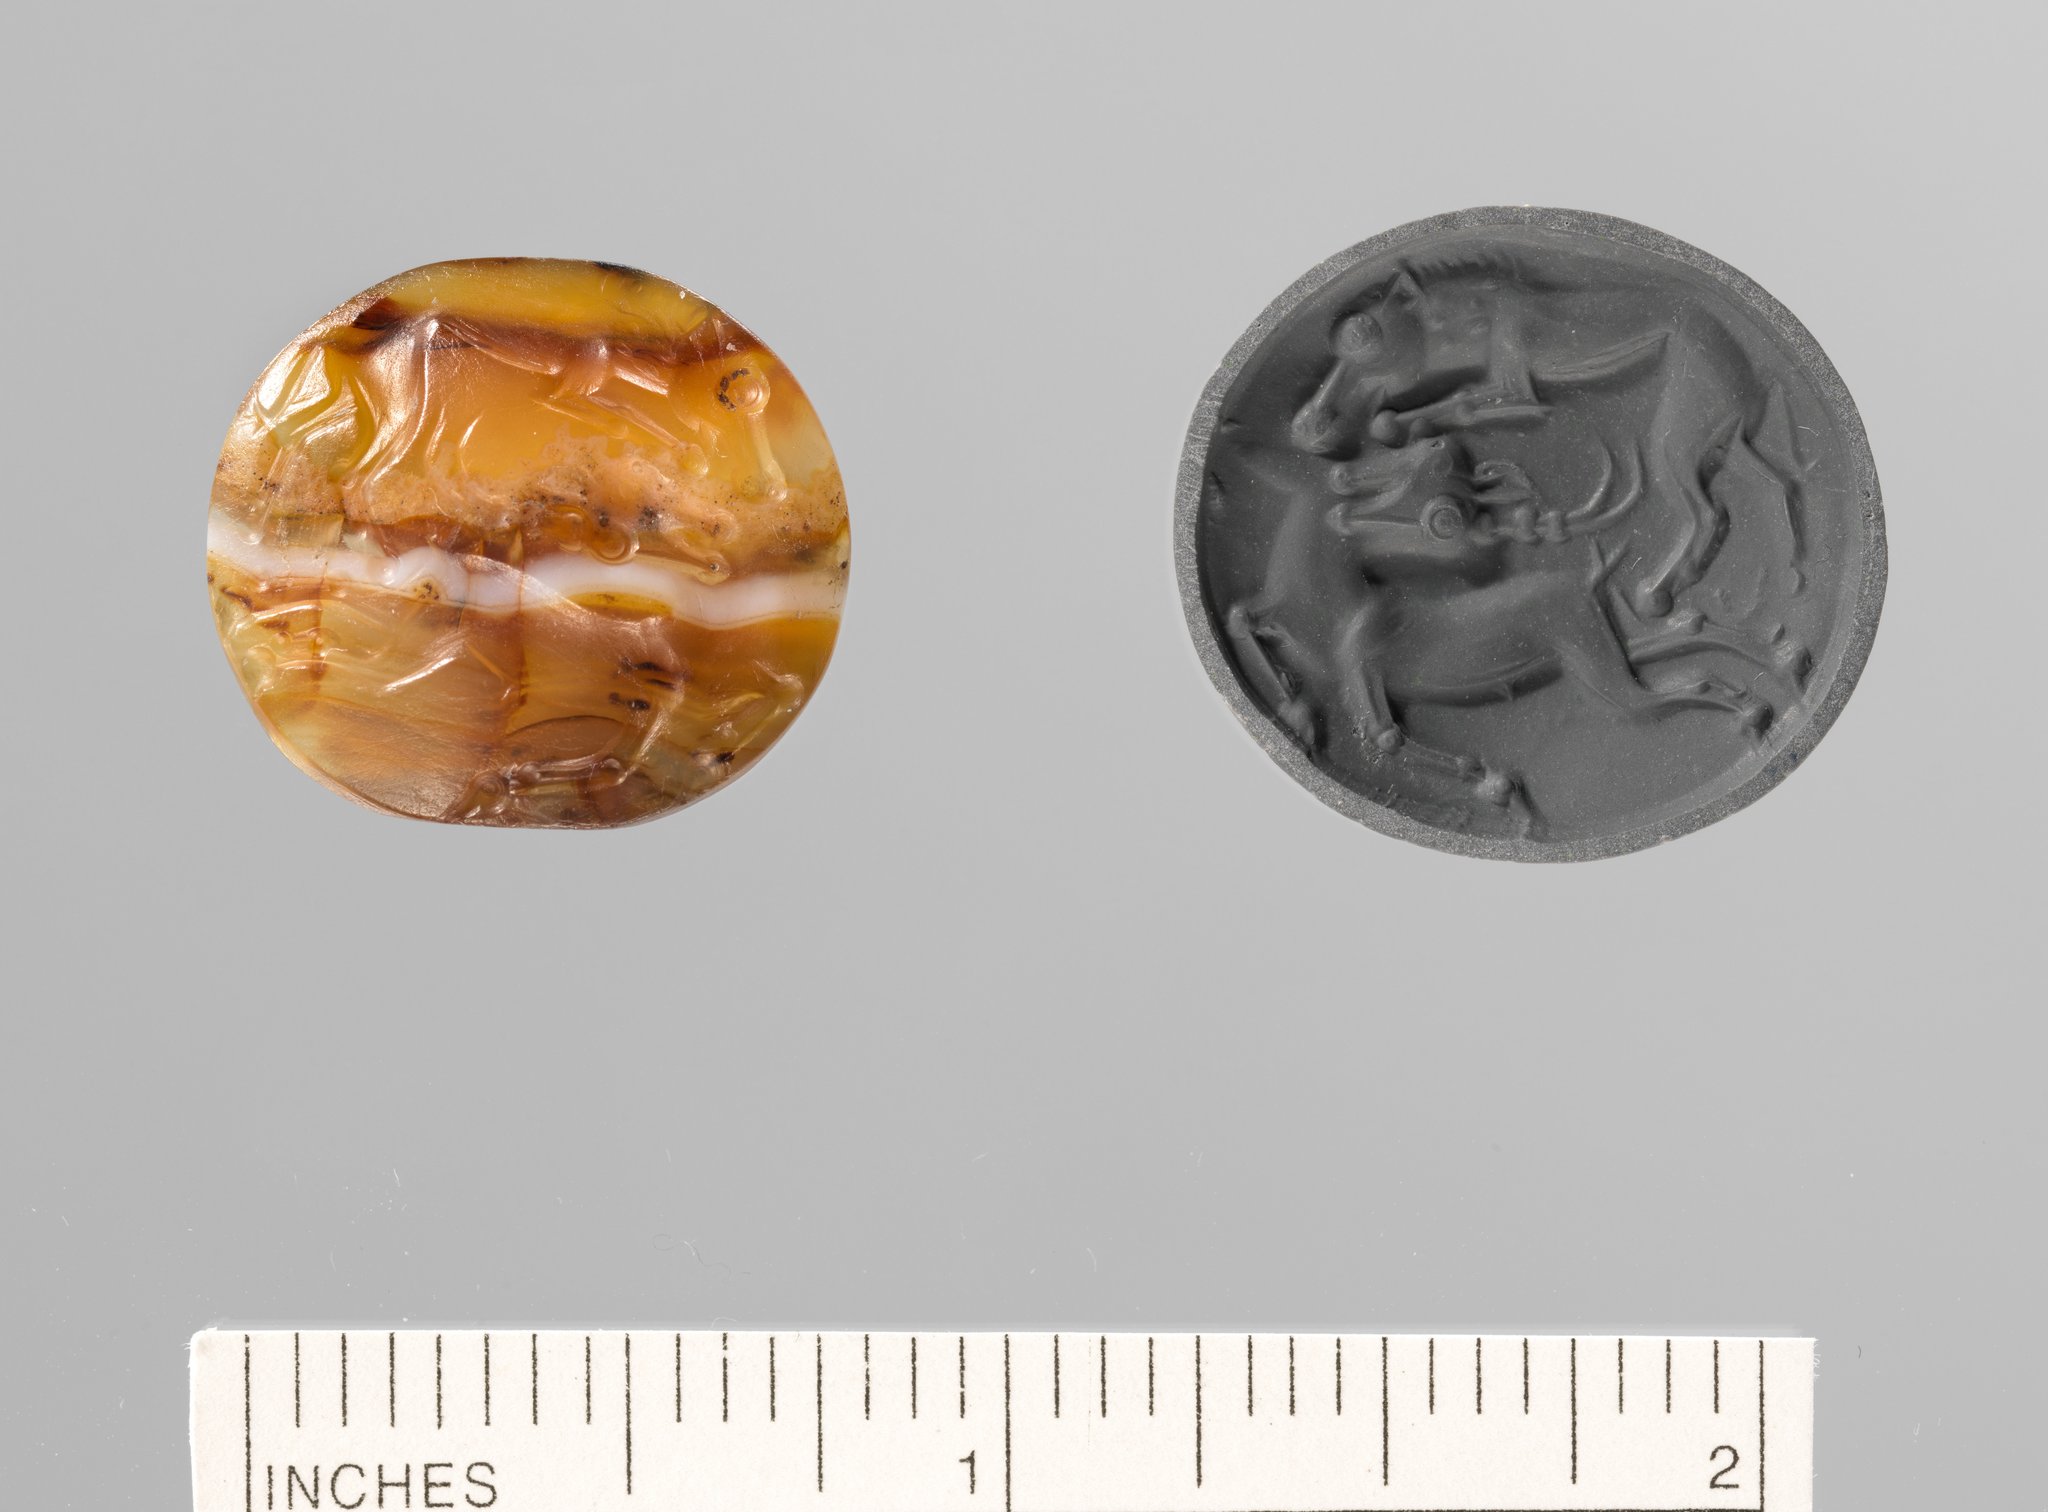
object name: seal, lentoid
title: Agate Lentoid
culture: minoan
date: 1400-1375 BCE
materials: stone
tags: goats,lions